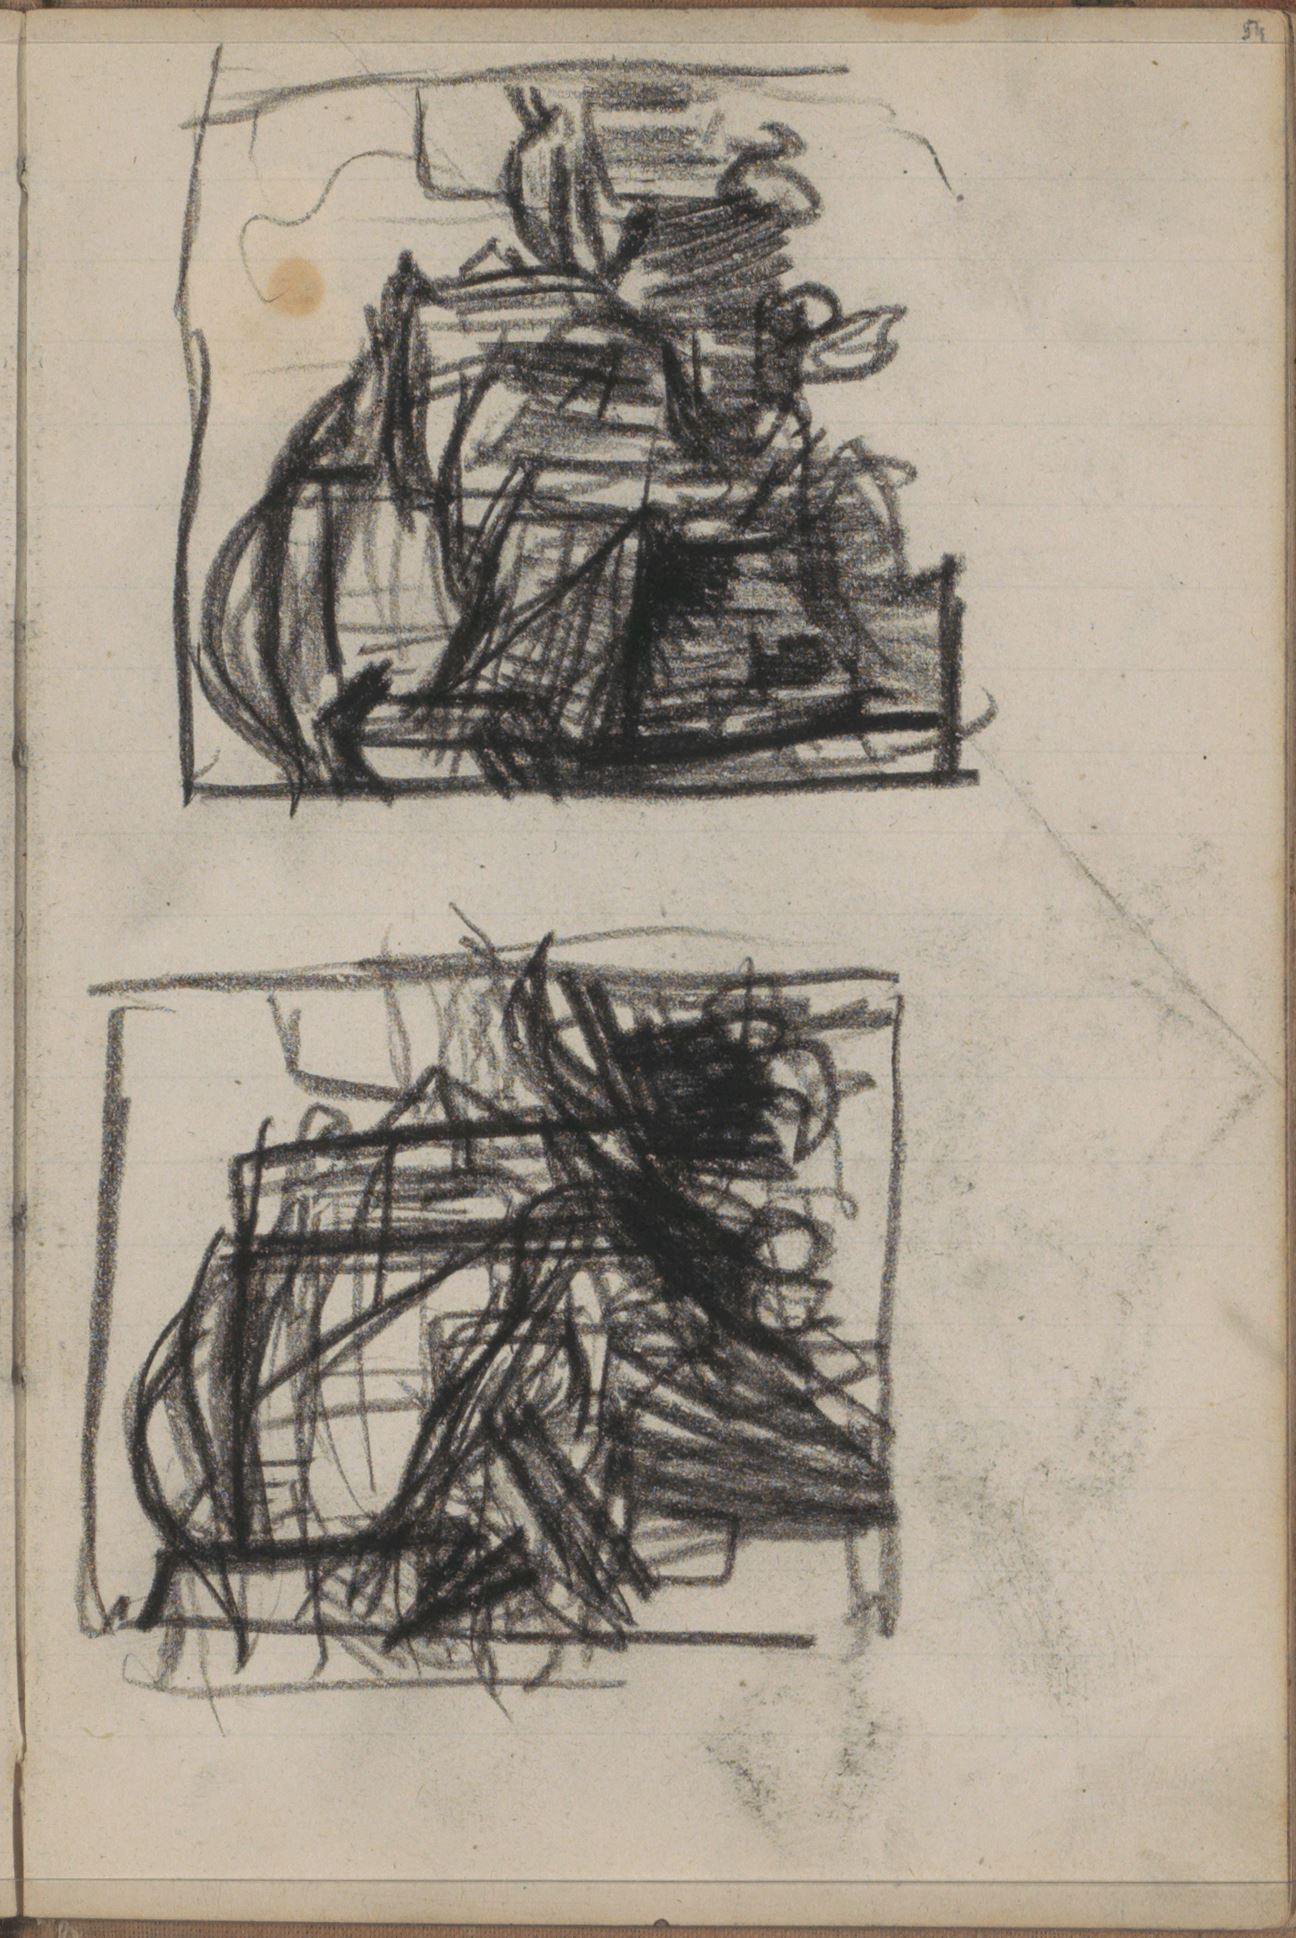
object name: sketchbook leaf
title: Straat met een gebouw met koepeldak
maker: marius bauer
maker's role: draughtsman, print maker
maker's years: 1867-1932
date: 1888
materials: chalk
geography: istanbul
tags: dome ~ architecture, street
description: Pagina 54 uit een schetsboek met 58 bladen.